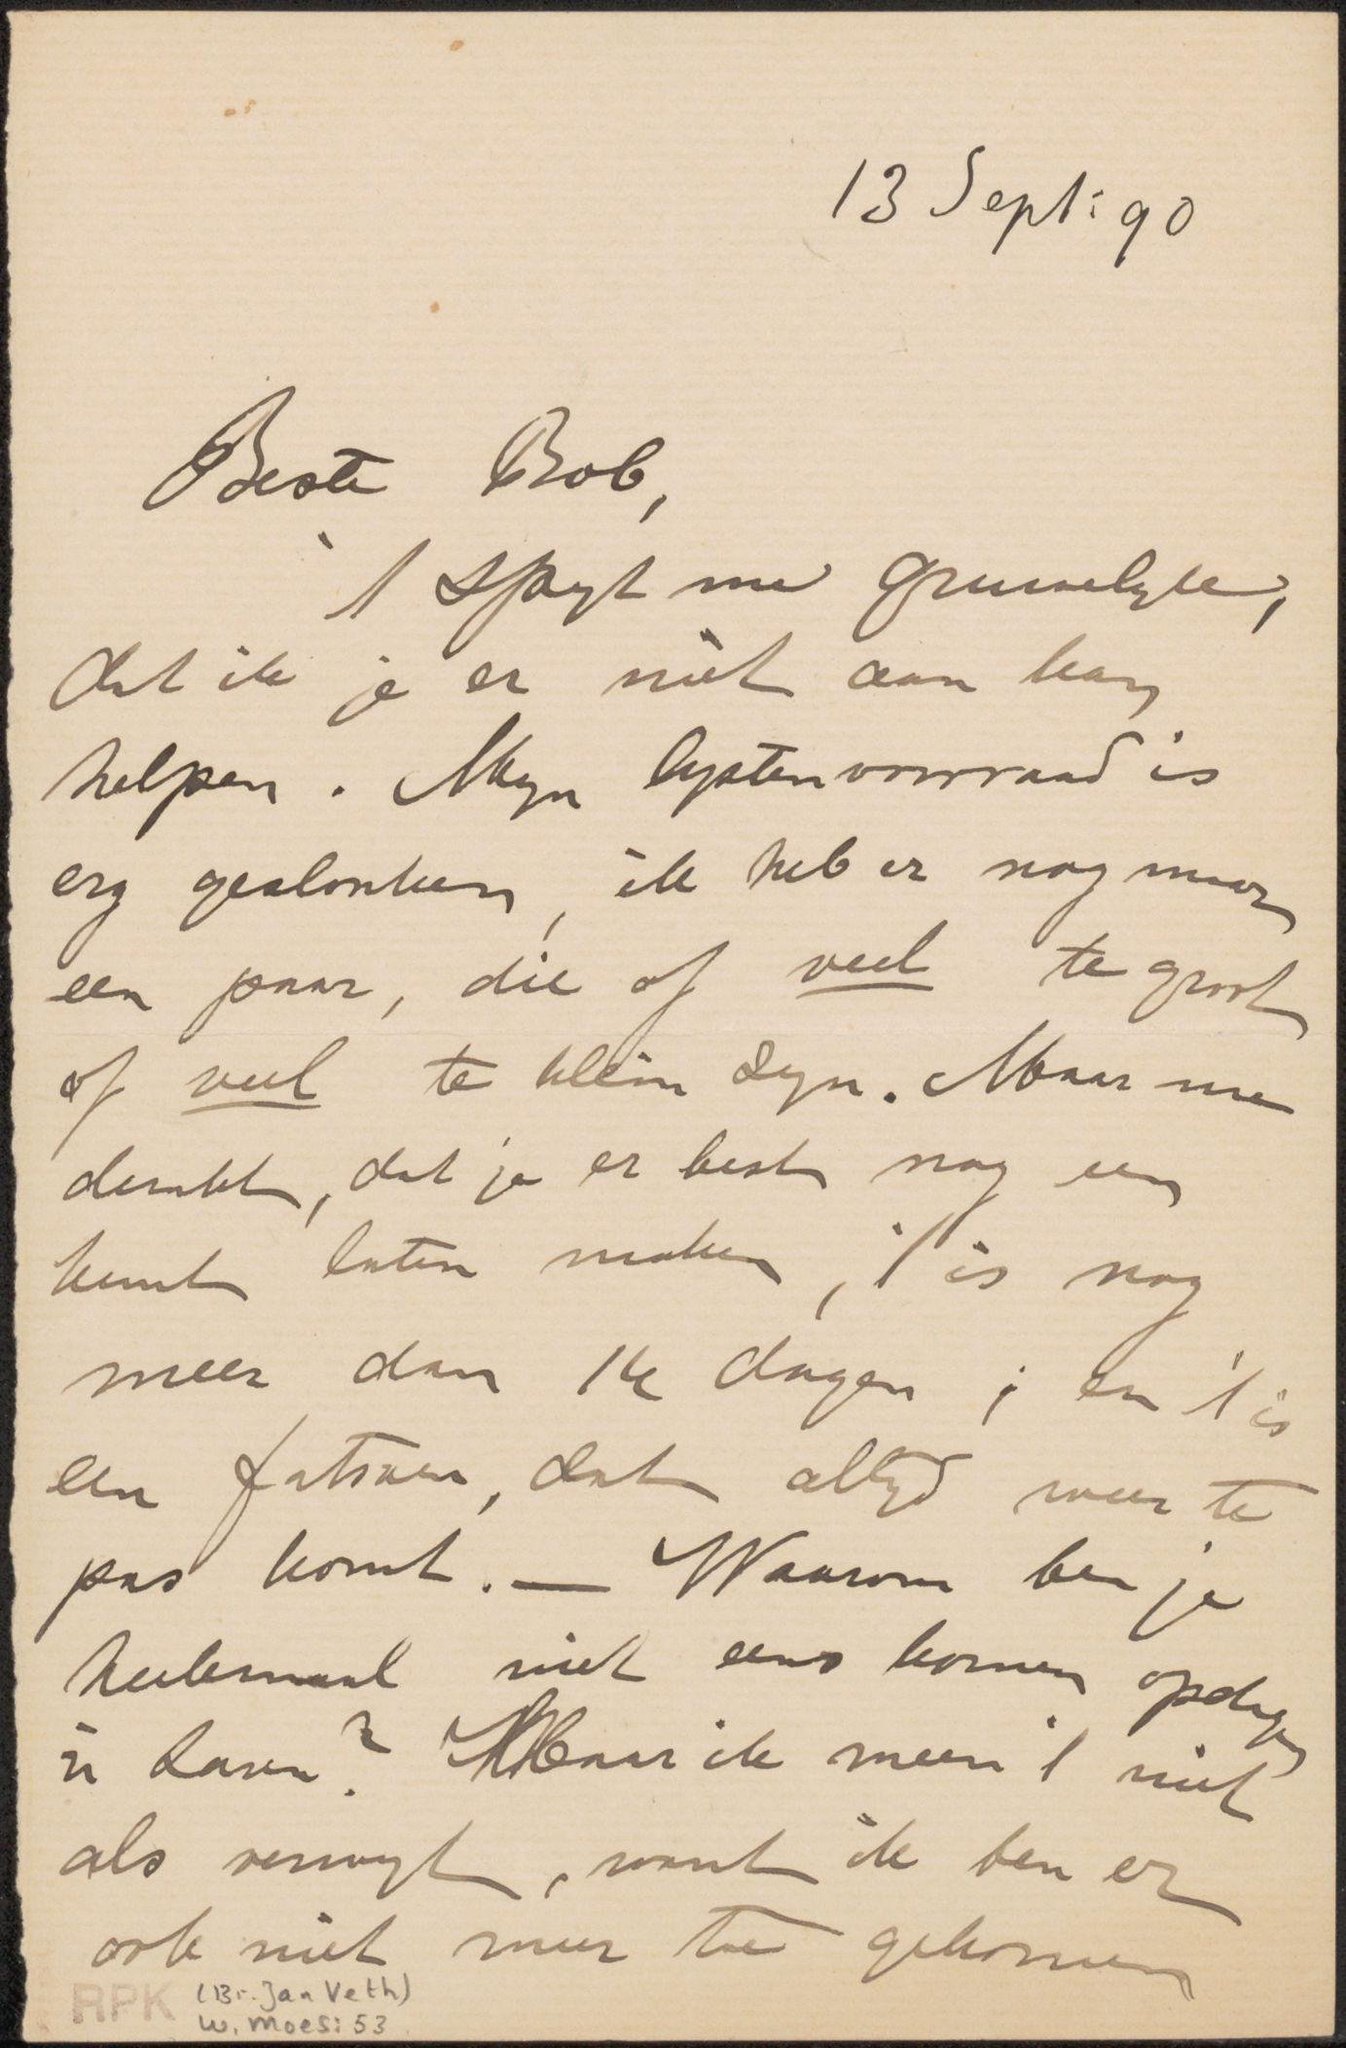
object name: letter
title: Brief aan Jan Veth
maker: wally moes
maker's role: draughtsman, print maker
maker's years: 1856-1918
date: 1874-1918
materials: ink, paper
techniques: pen, writing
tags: dordrecht, painter, designer, jan veth, applied arts, arts and crafts; industrial design, historical persons (portraits and scenes from the life), utrecht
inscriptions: collector's mark: ‘RPK’